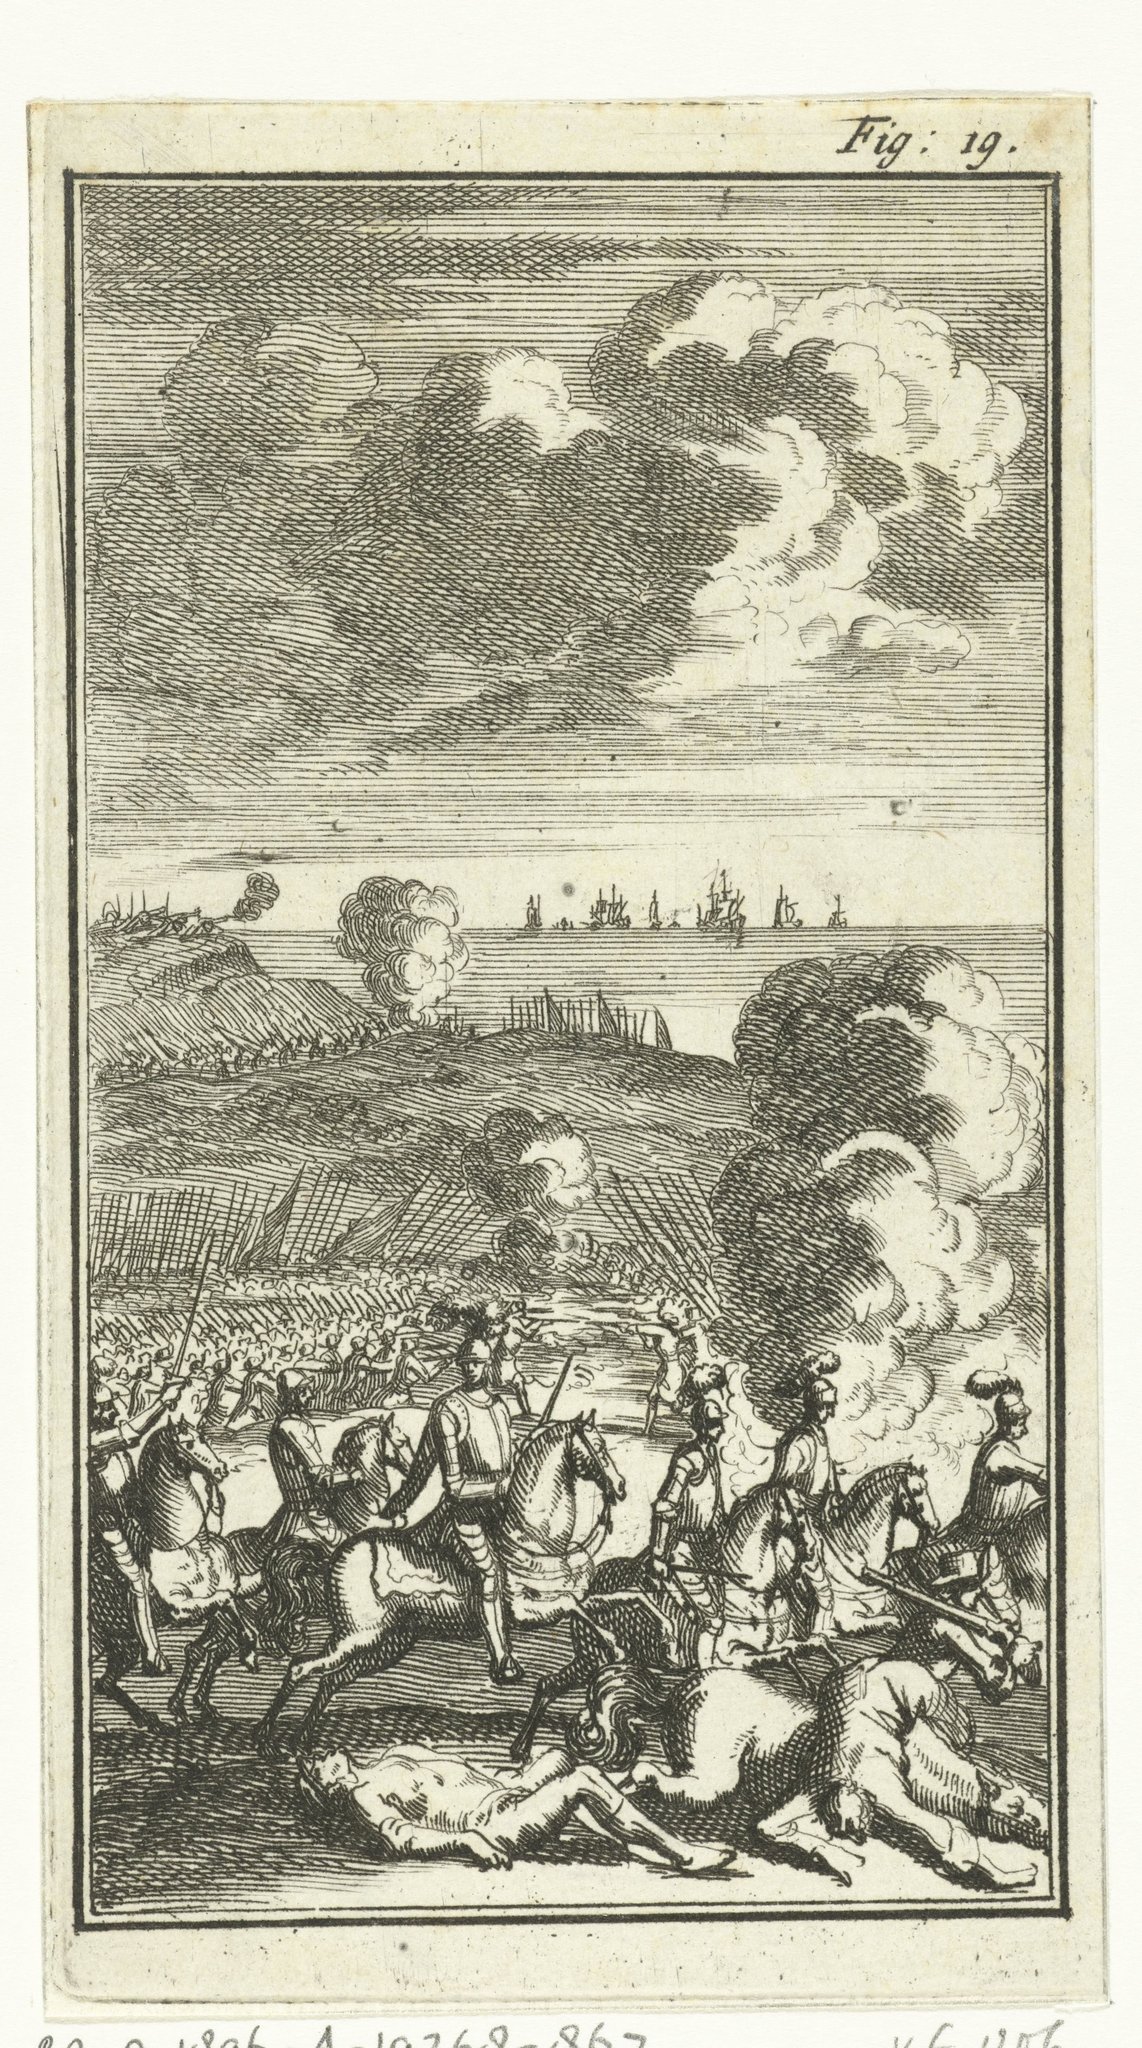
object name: book illustration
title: Slag bij Nieuwpoort, 1600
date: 1691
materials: paper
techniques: etching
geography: the hague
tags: battle (+ land forces), battle of nieuwpoort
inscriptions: collector's mark: Lugt 2228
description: Illustratie uit: Beeck, Barent. Le triomphe royal, où l'on voit dêscrits les arcs de triomphe (...) erigez à la Haye, à l'honneur de Guillaume III. Den Haag, 1691.